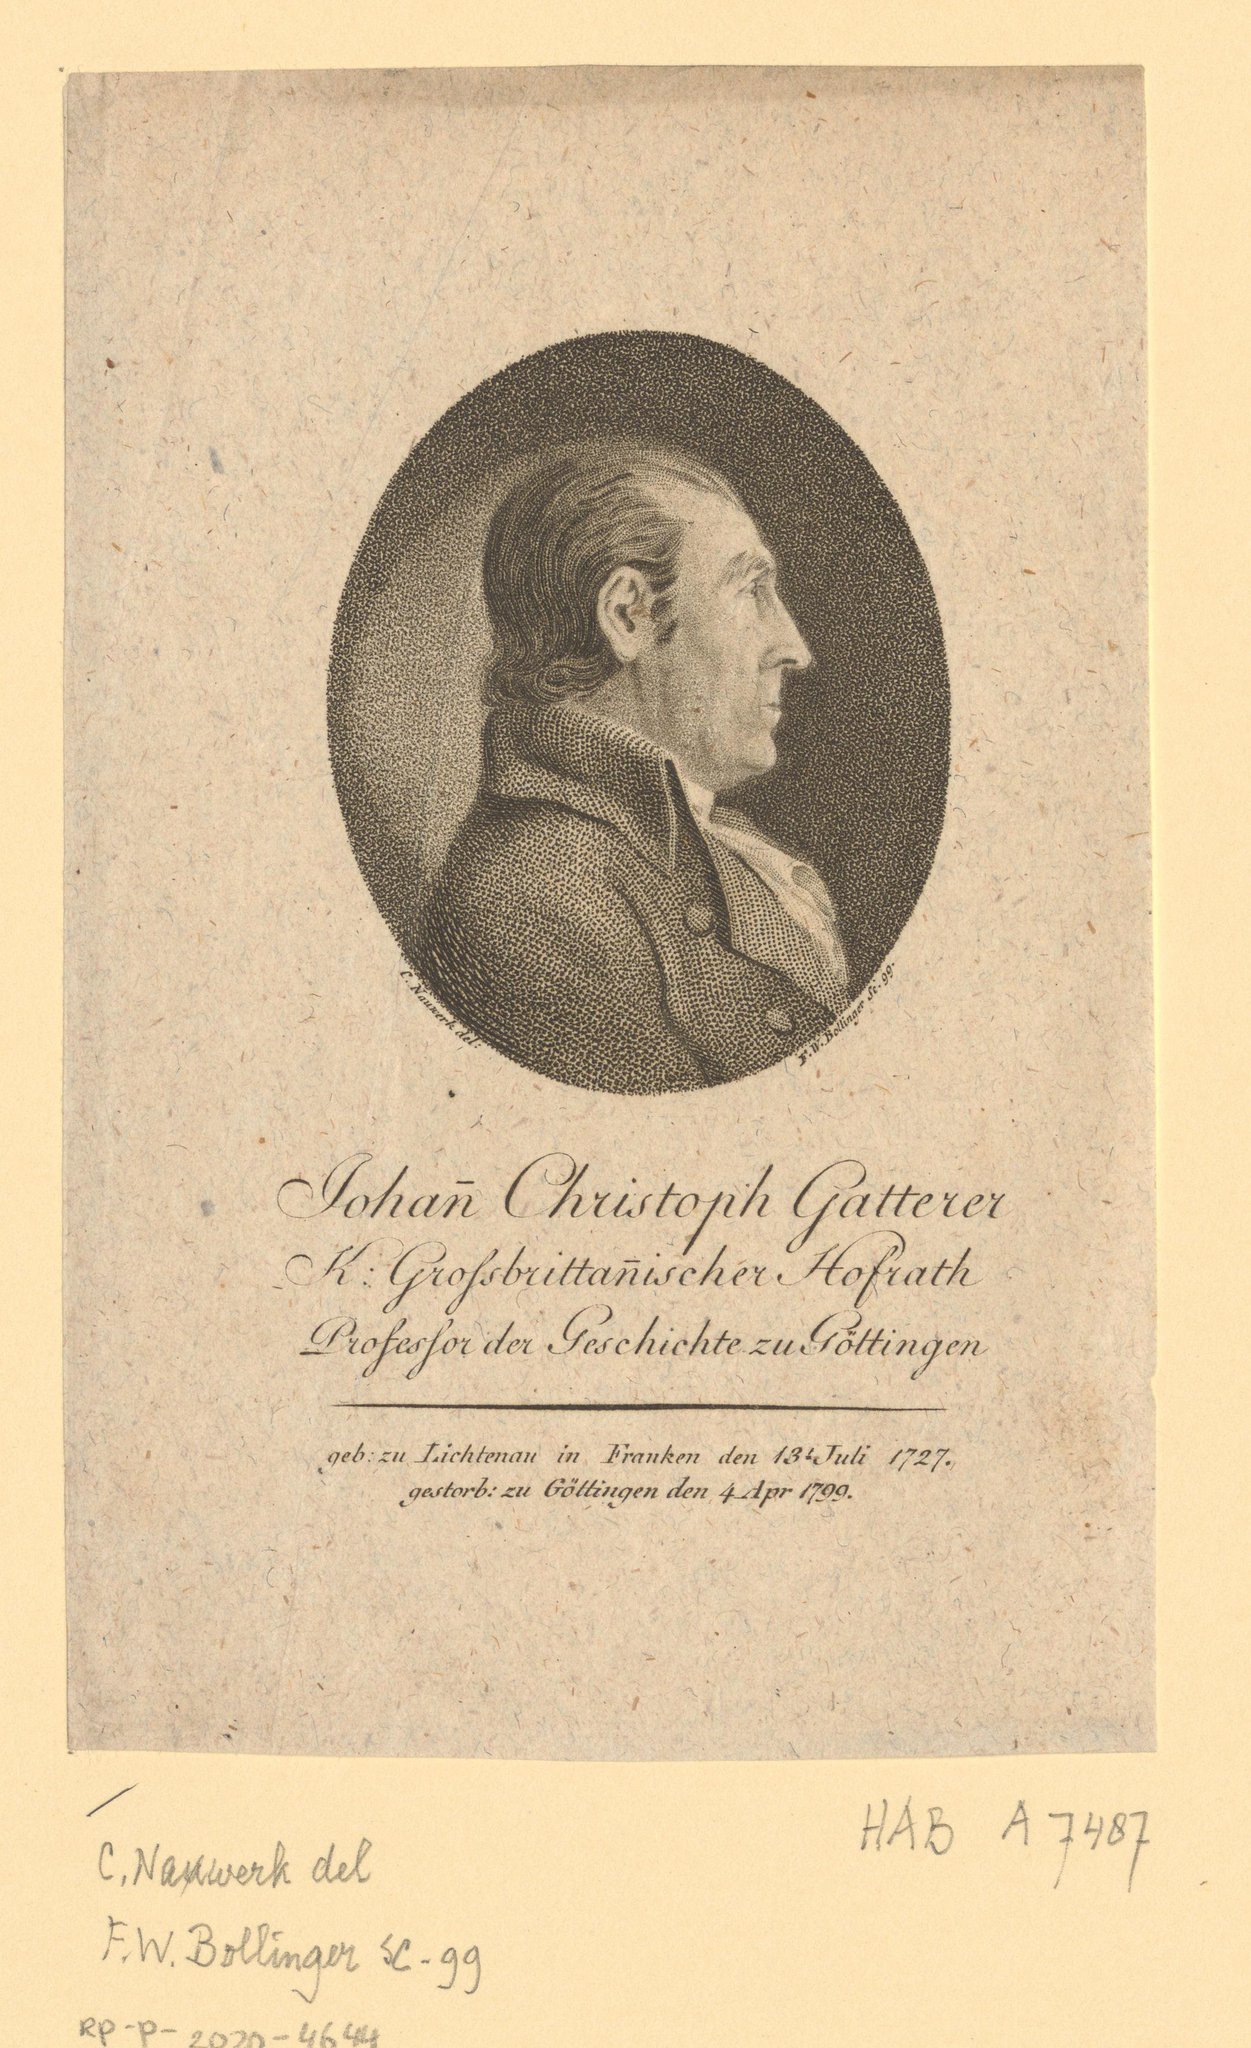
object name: print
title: Portret van Johann Christoph Gatterer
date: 1799-1825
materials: paper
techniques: stippling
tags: historical persons, professor